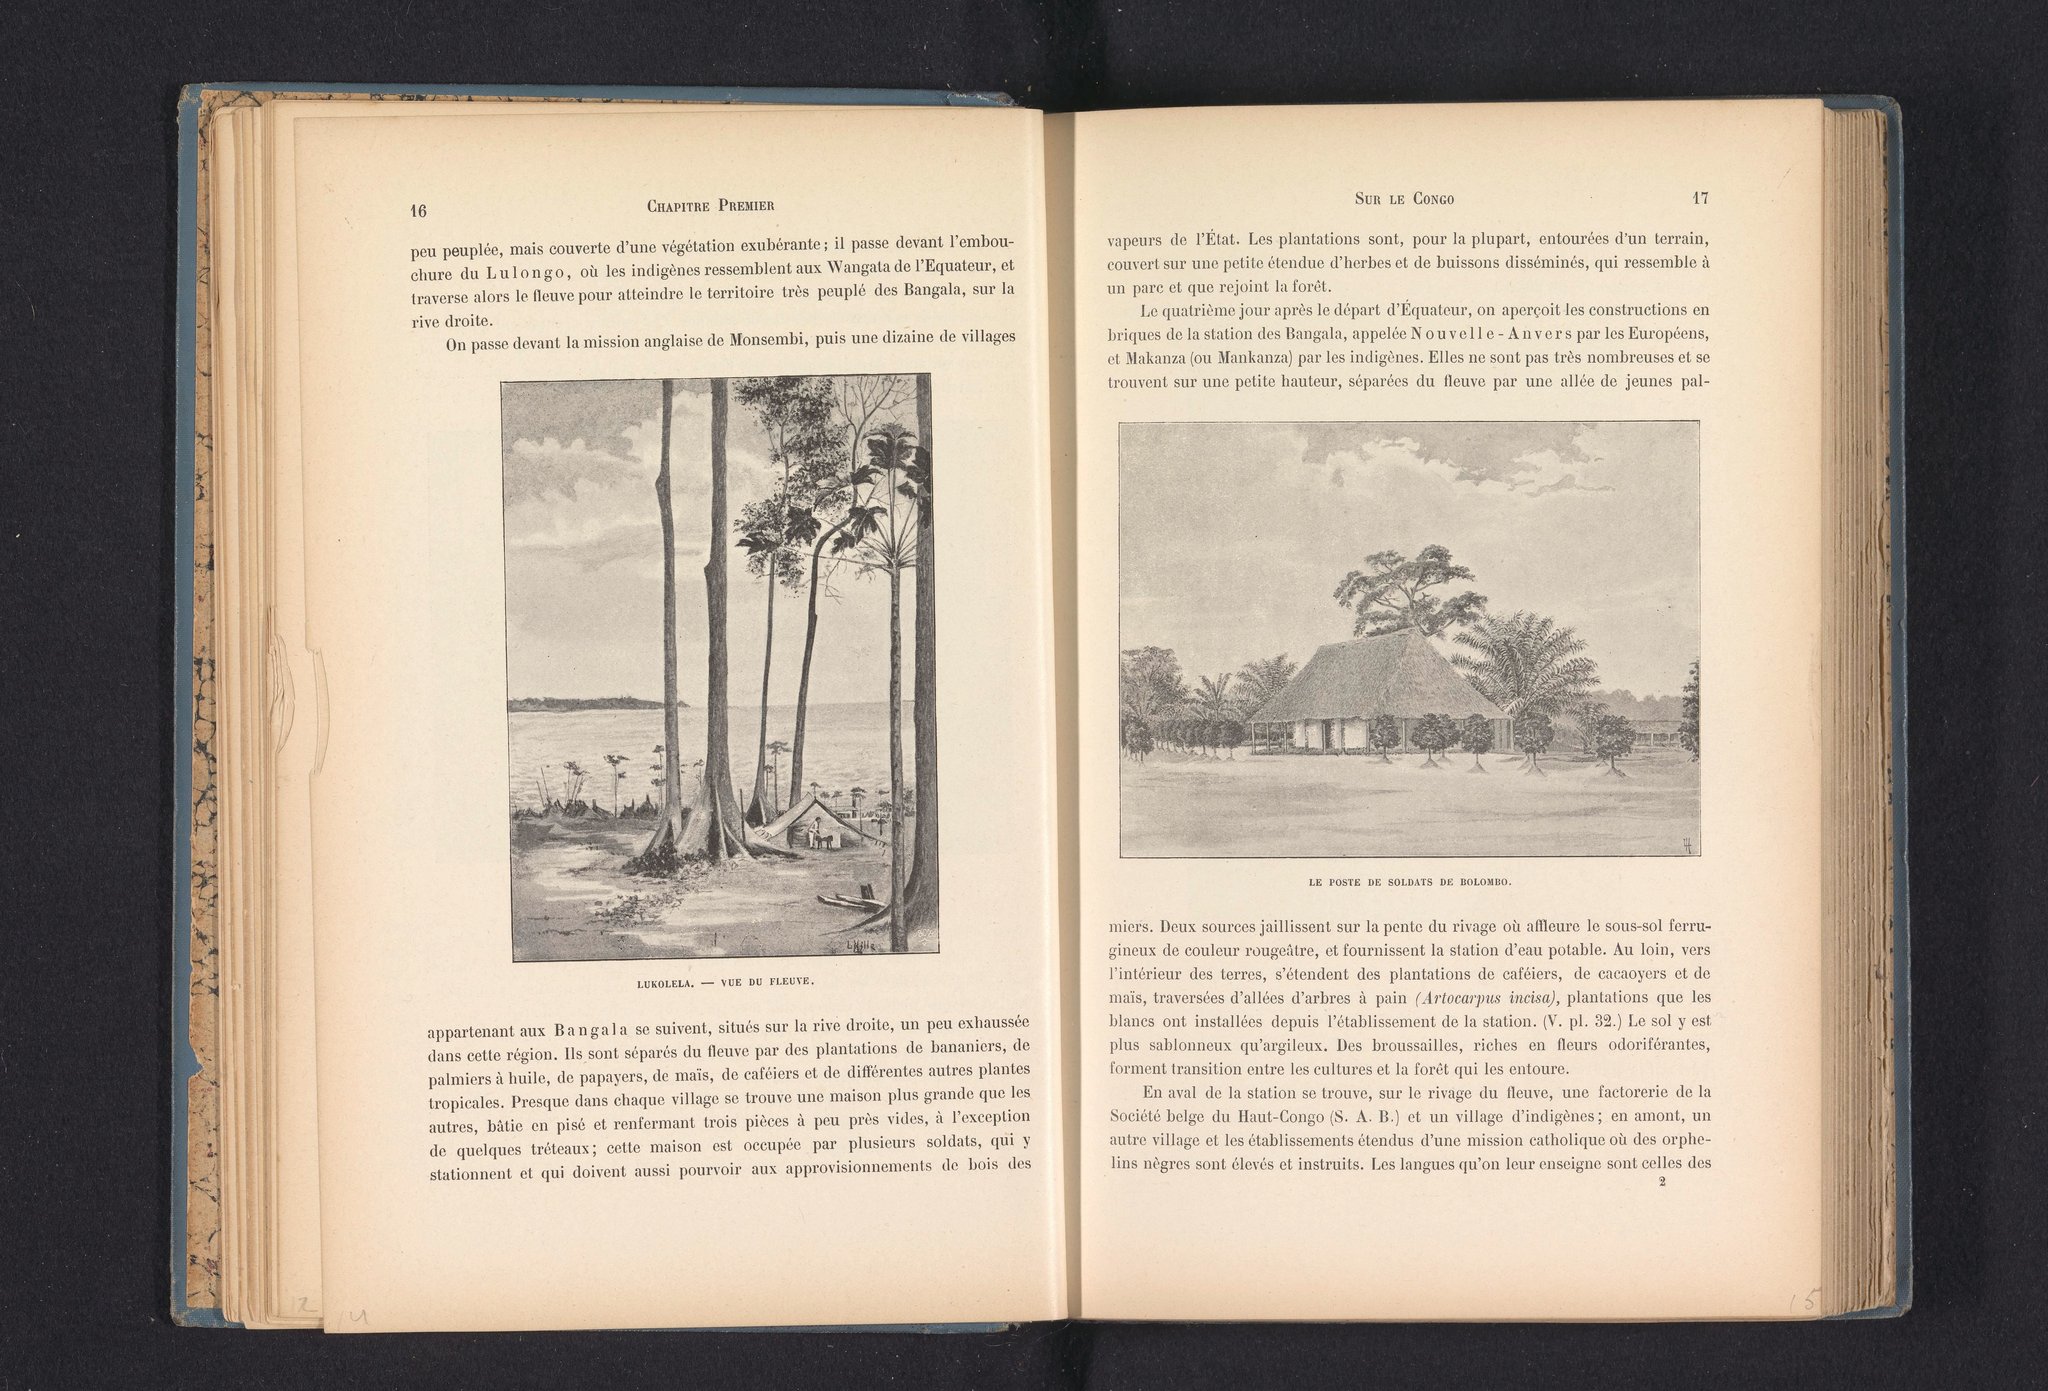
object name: reproduction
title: Fotoreproductie van een tekening, voorstellende een barak nabij de Bolombo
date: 1896-1899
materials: paper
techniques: autotype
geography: congo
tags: façade (of house or building), barracks